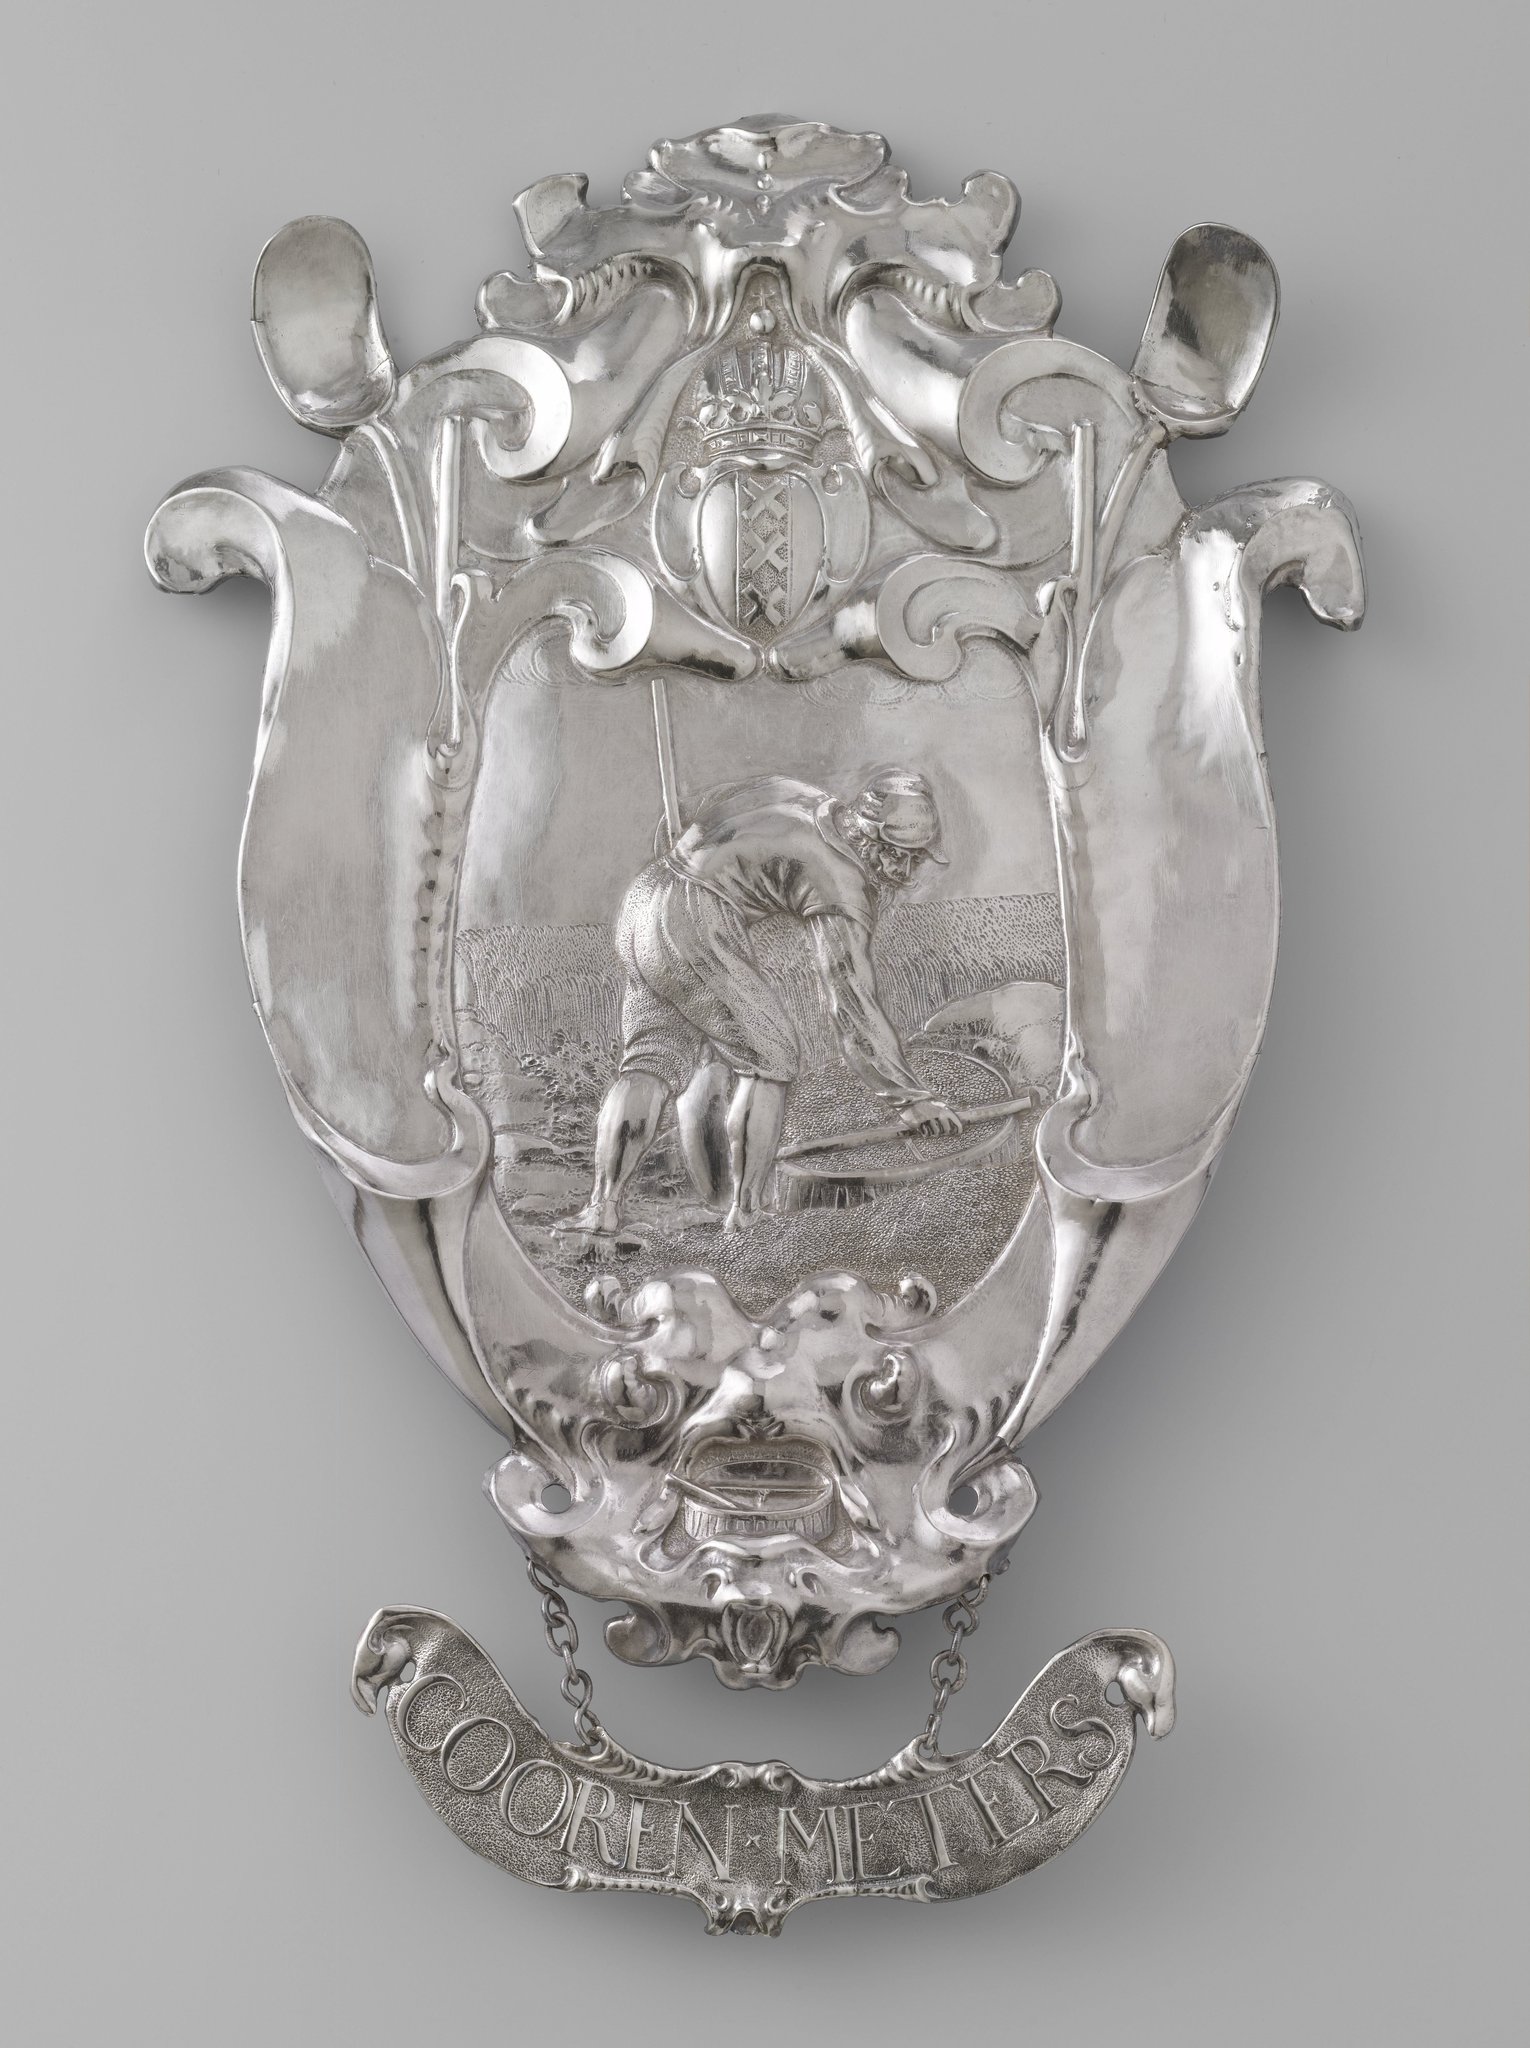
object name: begrafenisschild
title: Four Funeral Shields of the Amsterdam Guild of Corn Measurers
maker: johannes lutma (1584-1669)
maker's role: draughtsman, print maker, silversmith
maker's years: 1584-1669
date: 1633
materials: silver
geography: amsterdam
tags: auricular ornament, lobe style ~ ornament, cereal, grain, corn (grass with grains, grown for food, e.g.: wheat, rice, rye, oats, maize, buckwheat, millet) (+ labourers ~ crafts, industries, agriculture), amsterdam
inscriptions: date letter: ‘B’, maker's mark, town mark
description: At the funeral of a member of the guild of corn measurers, these shields were suspended from the coffin, draped in black. The powerful surrounds are reminiscent of bones, but they are also folded like skin. The large auricular ornament is meant to be effective when seen from a distance. These shields are Johannes Lutmaâ€™s earliest known works in silver.